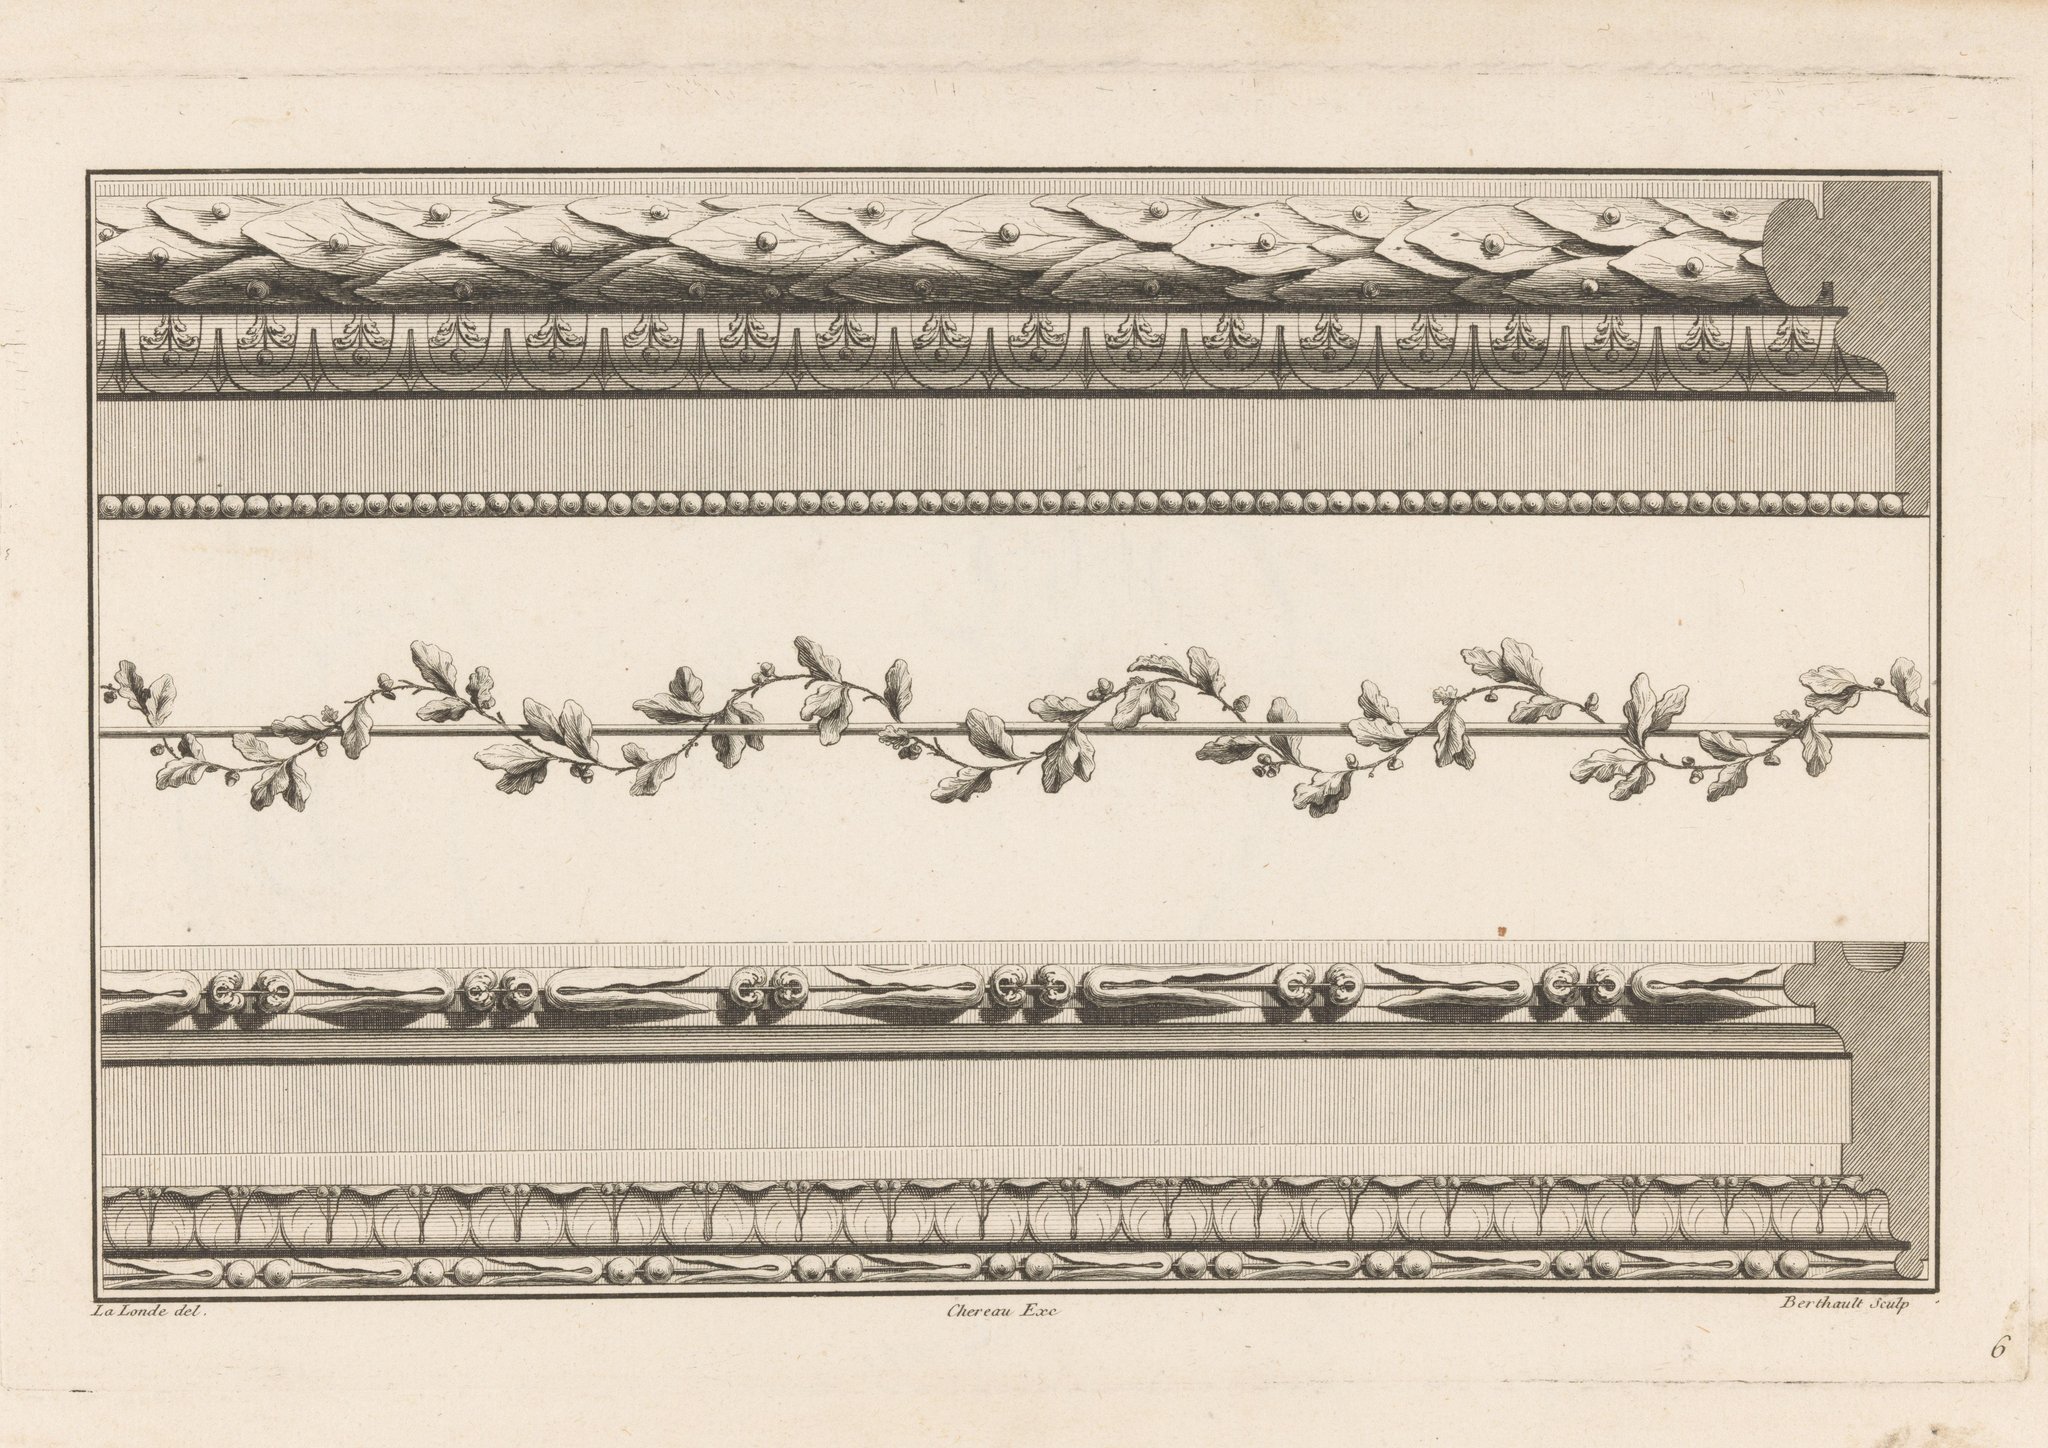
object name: print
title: Drie lijsten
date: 1784-1785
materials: paper, pencil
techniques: engraving, etching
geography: paris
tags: ornaments ~ art (+ framing decorations)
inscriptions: collector's mark: Lugt 2760, collector's mark: Lugt 2228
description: Een lijst met bladmotieven, een lijst met een rank van eikenbladeren en een lijst met tulpen en bladmotieven. Verso tekening van een gezicht.